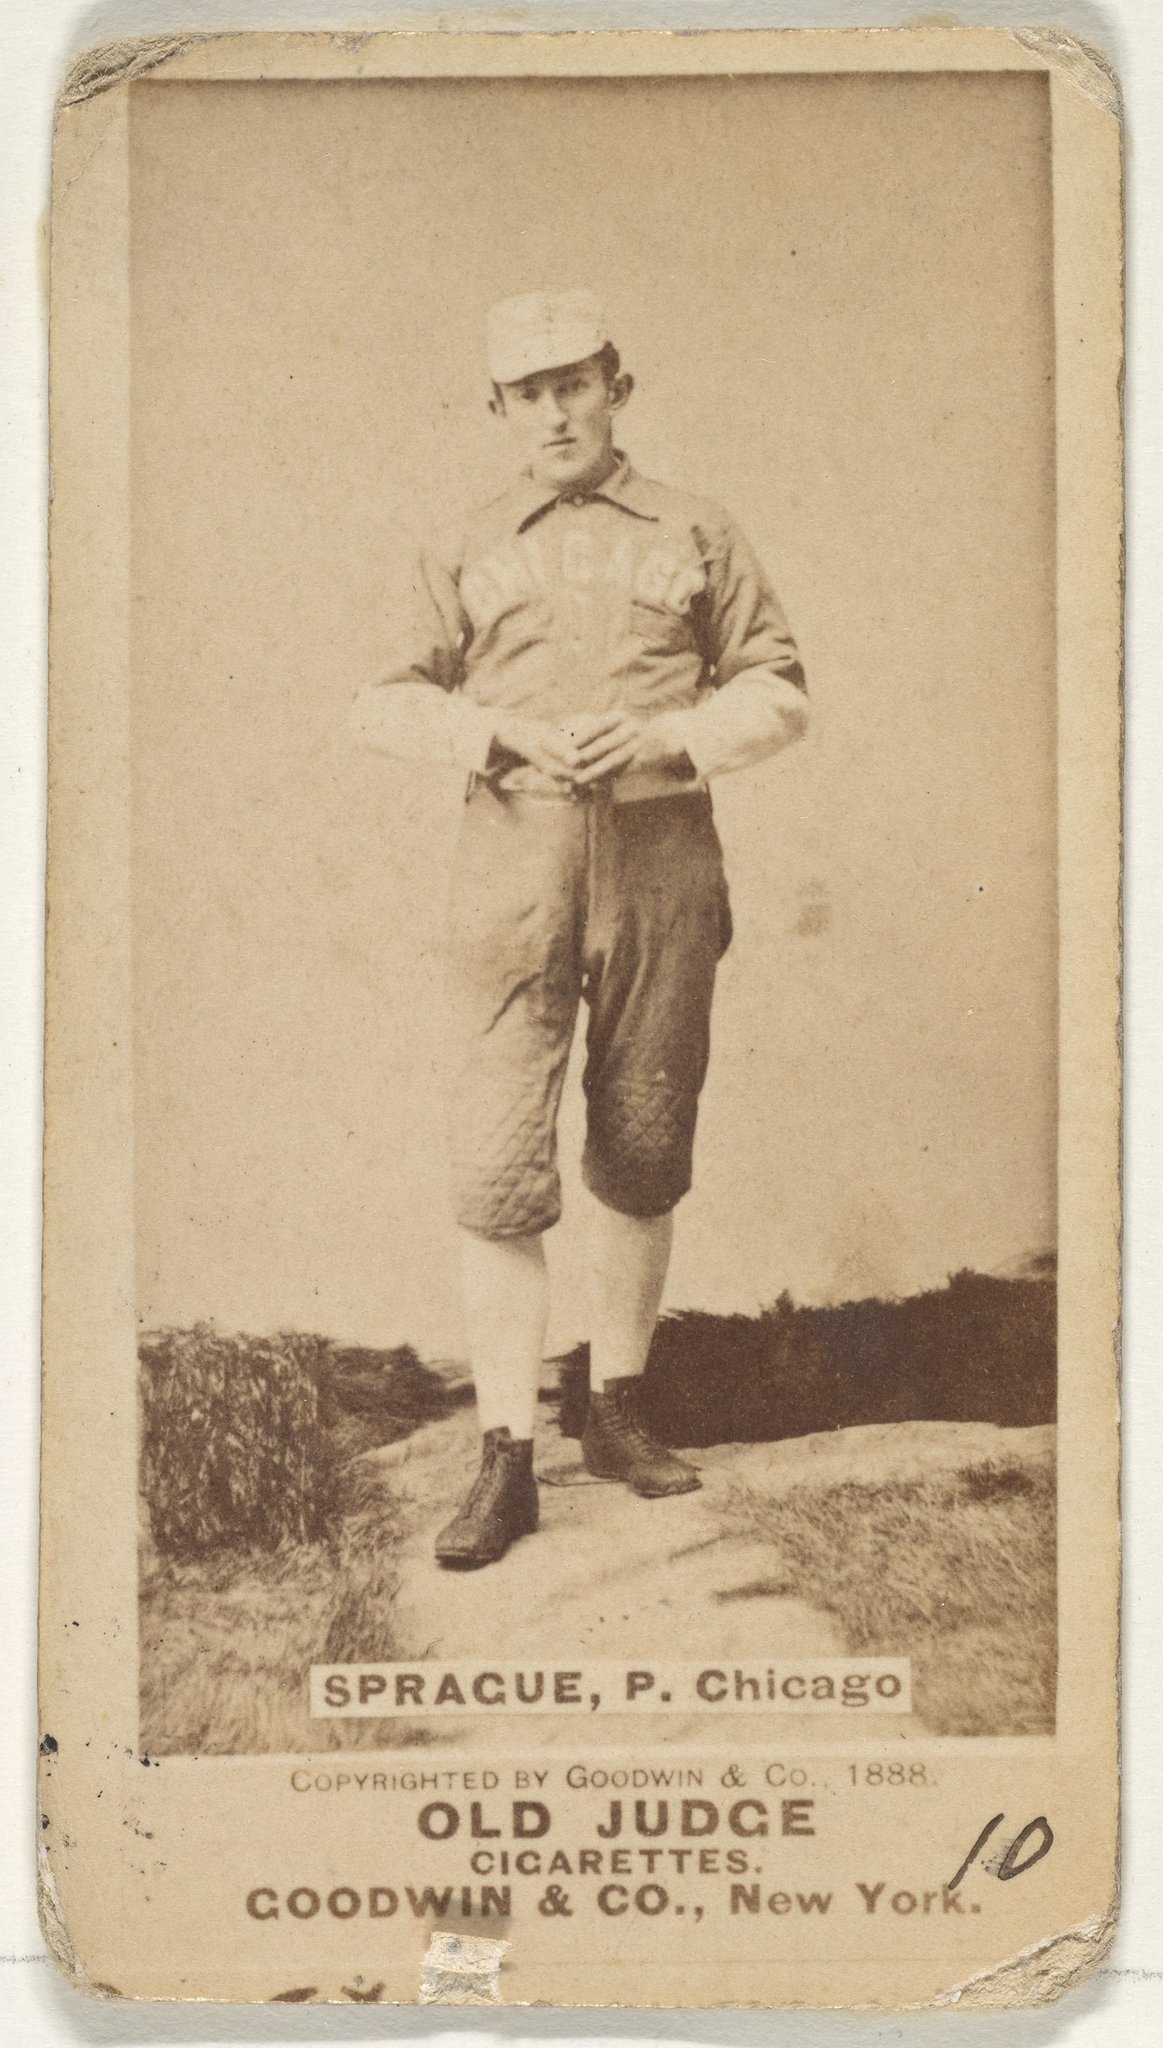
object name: baseball card, photograph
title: Sprague, Pitcher, Chicago, from the Old Judge series (N172) for Old Judge Cigarettes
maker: goodwin & company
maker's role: publisher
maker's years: 1850-1950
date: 1888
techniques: albumen silver print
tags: men,portraits,baseball,athletes